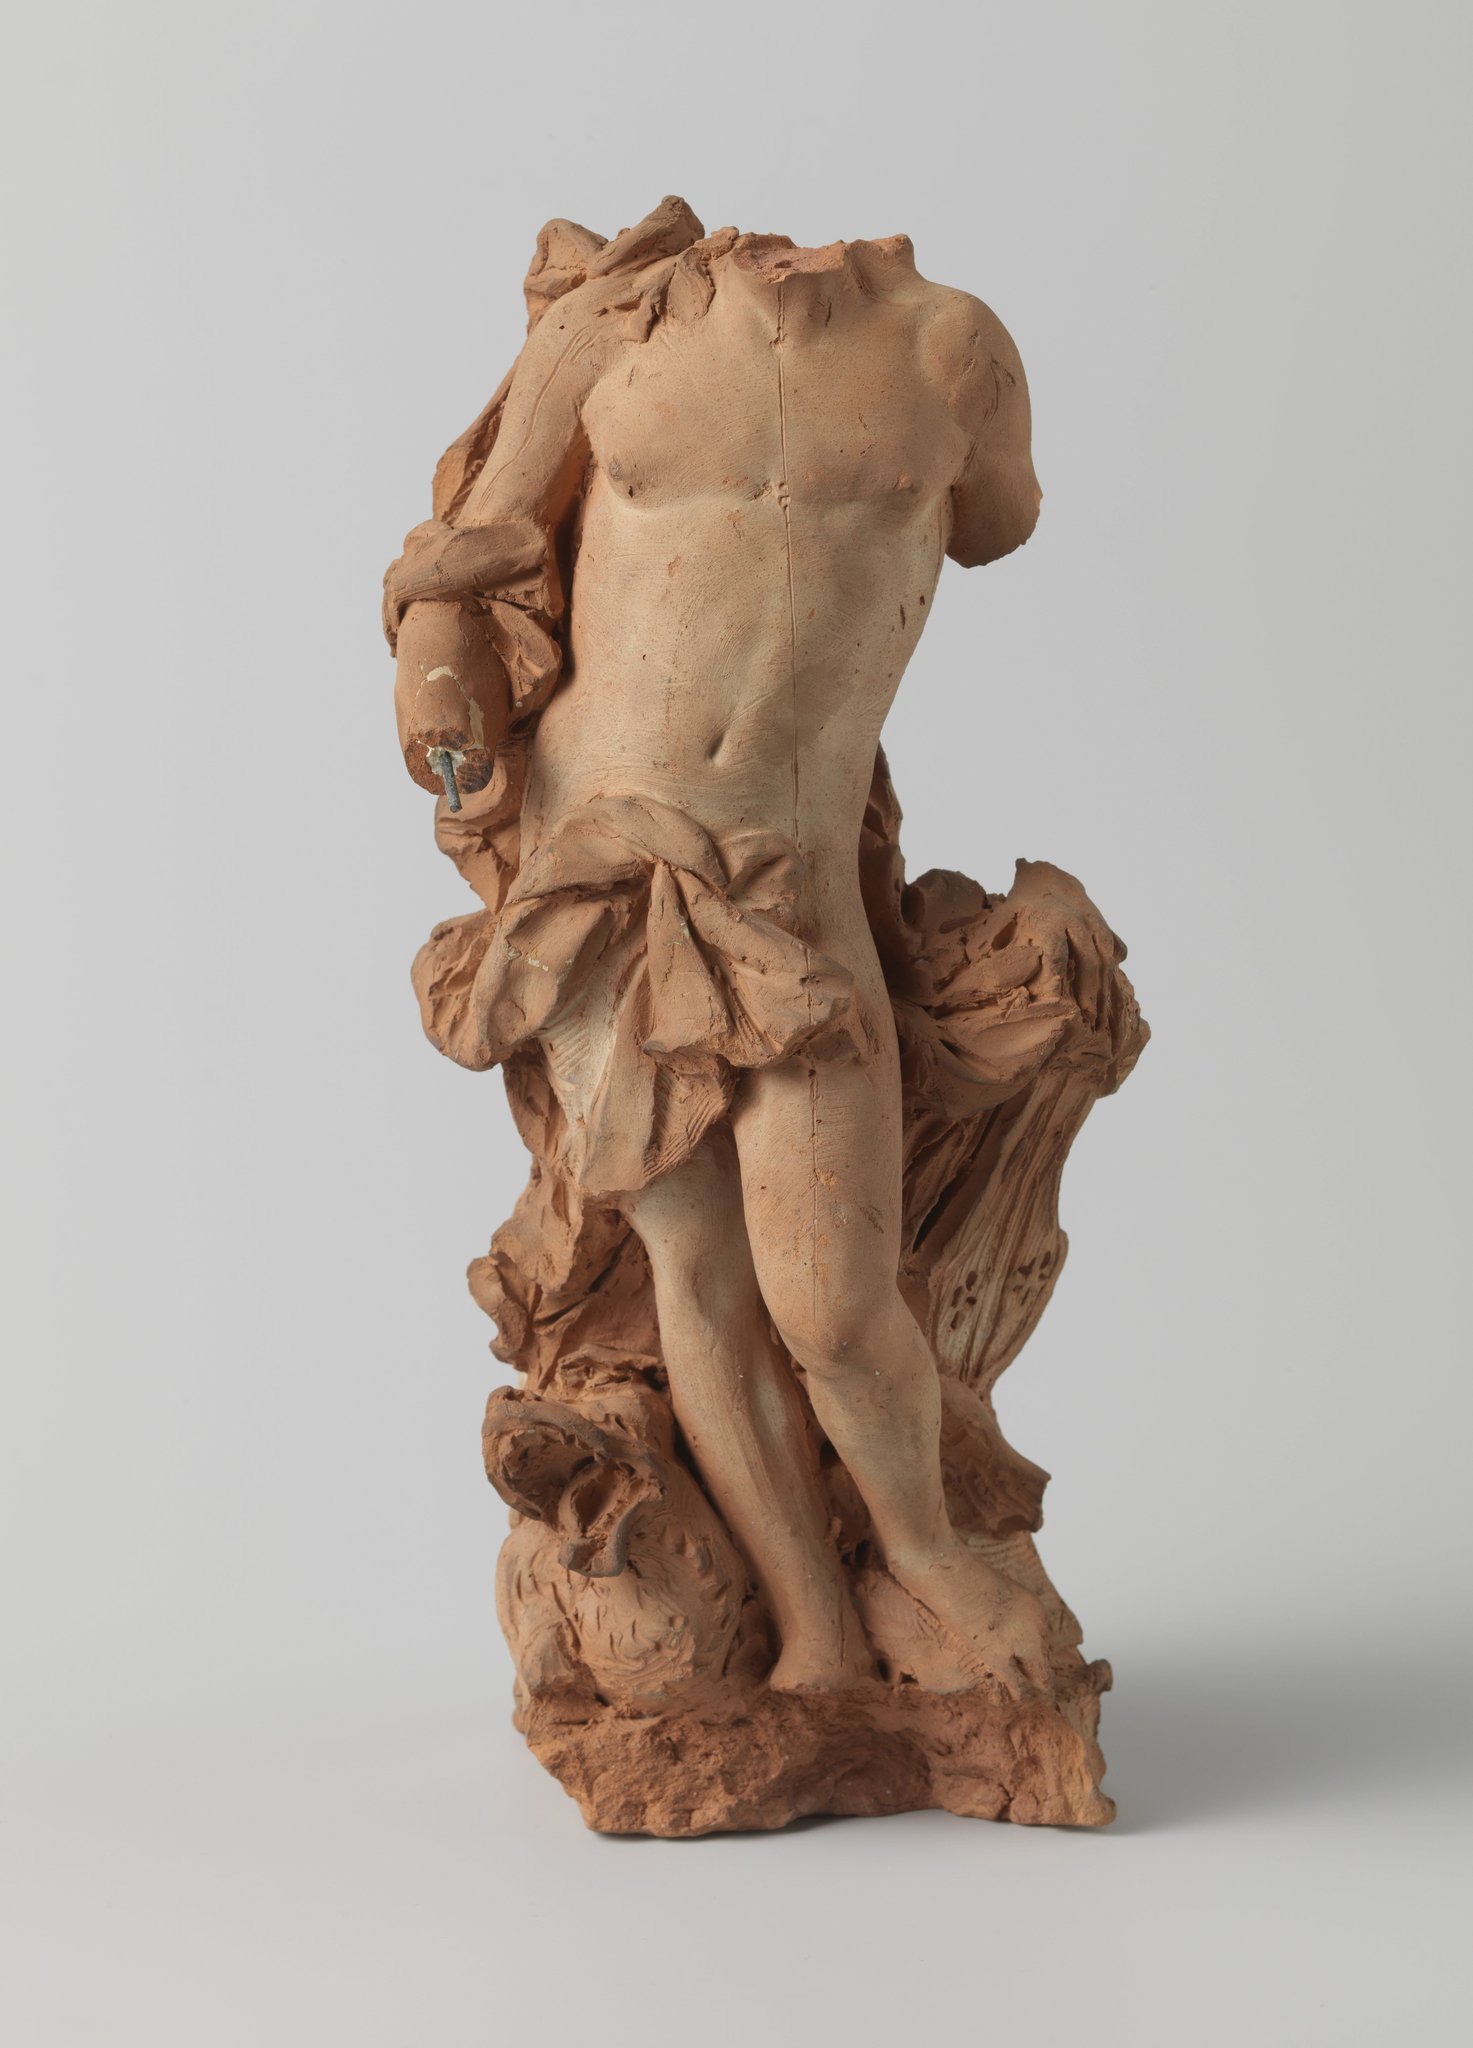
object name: study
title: Studie van een staande Apollo met lier, voor een tuinbeeld.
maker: ignatius van logteren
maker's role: sculptor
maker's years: 1685-1732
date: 1725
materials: terracotta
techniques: modeling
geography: amsterdam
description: Studie in terracotta, slordig gemodelleerd, van een staande Apollo met lier, voor een tuinbeeld, met aan zijn voeten een draak; rondom een draperie, verder naakt. Ingekraste werklijnen over het lichaam en been. Hoofd en linkerhand ontbreken, evenals een deel van de voorzijde van de plint. Apollo is een pendant van Diana (BK-1996-22) Opmerking: deze ongesigneerde Apollo is een voorstudie voor een tuinbeeld in zandsteen dat zich bevindt op de buitenplaats.....